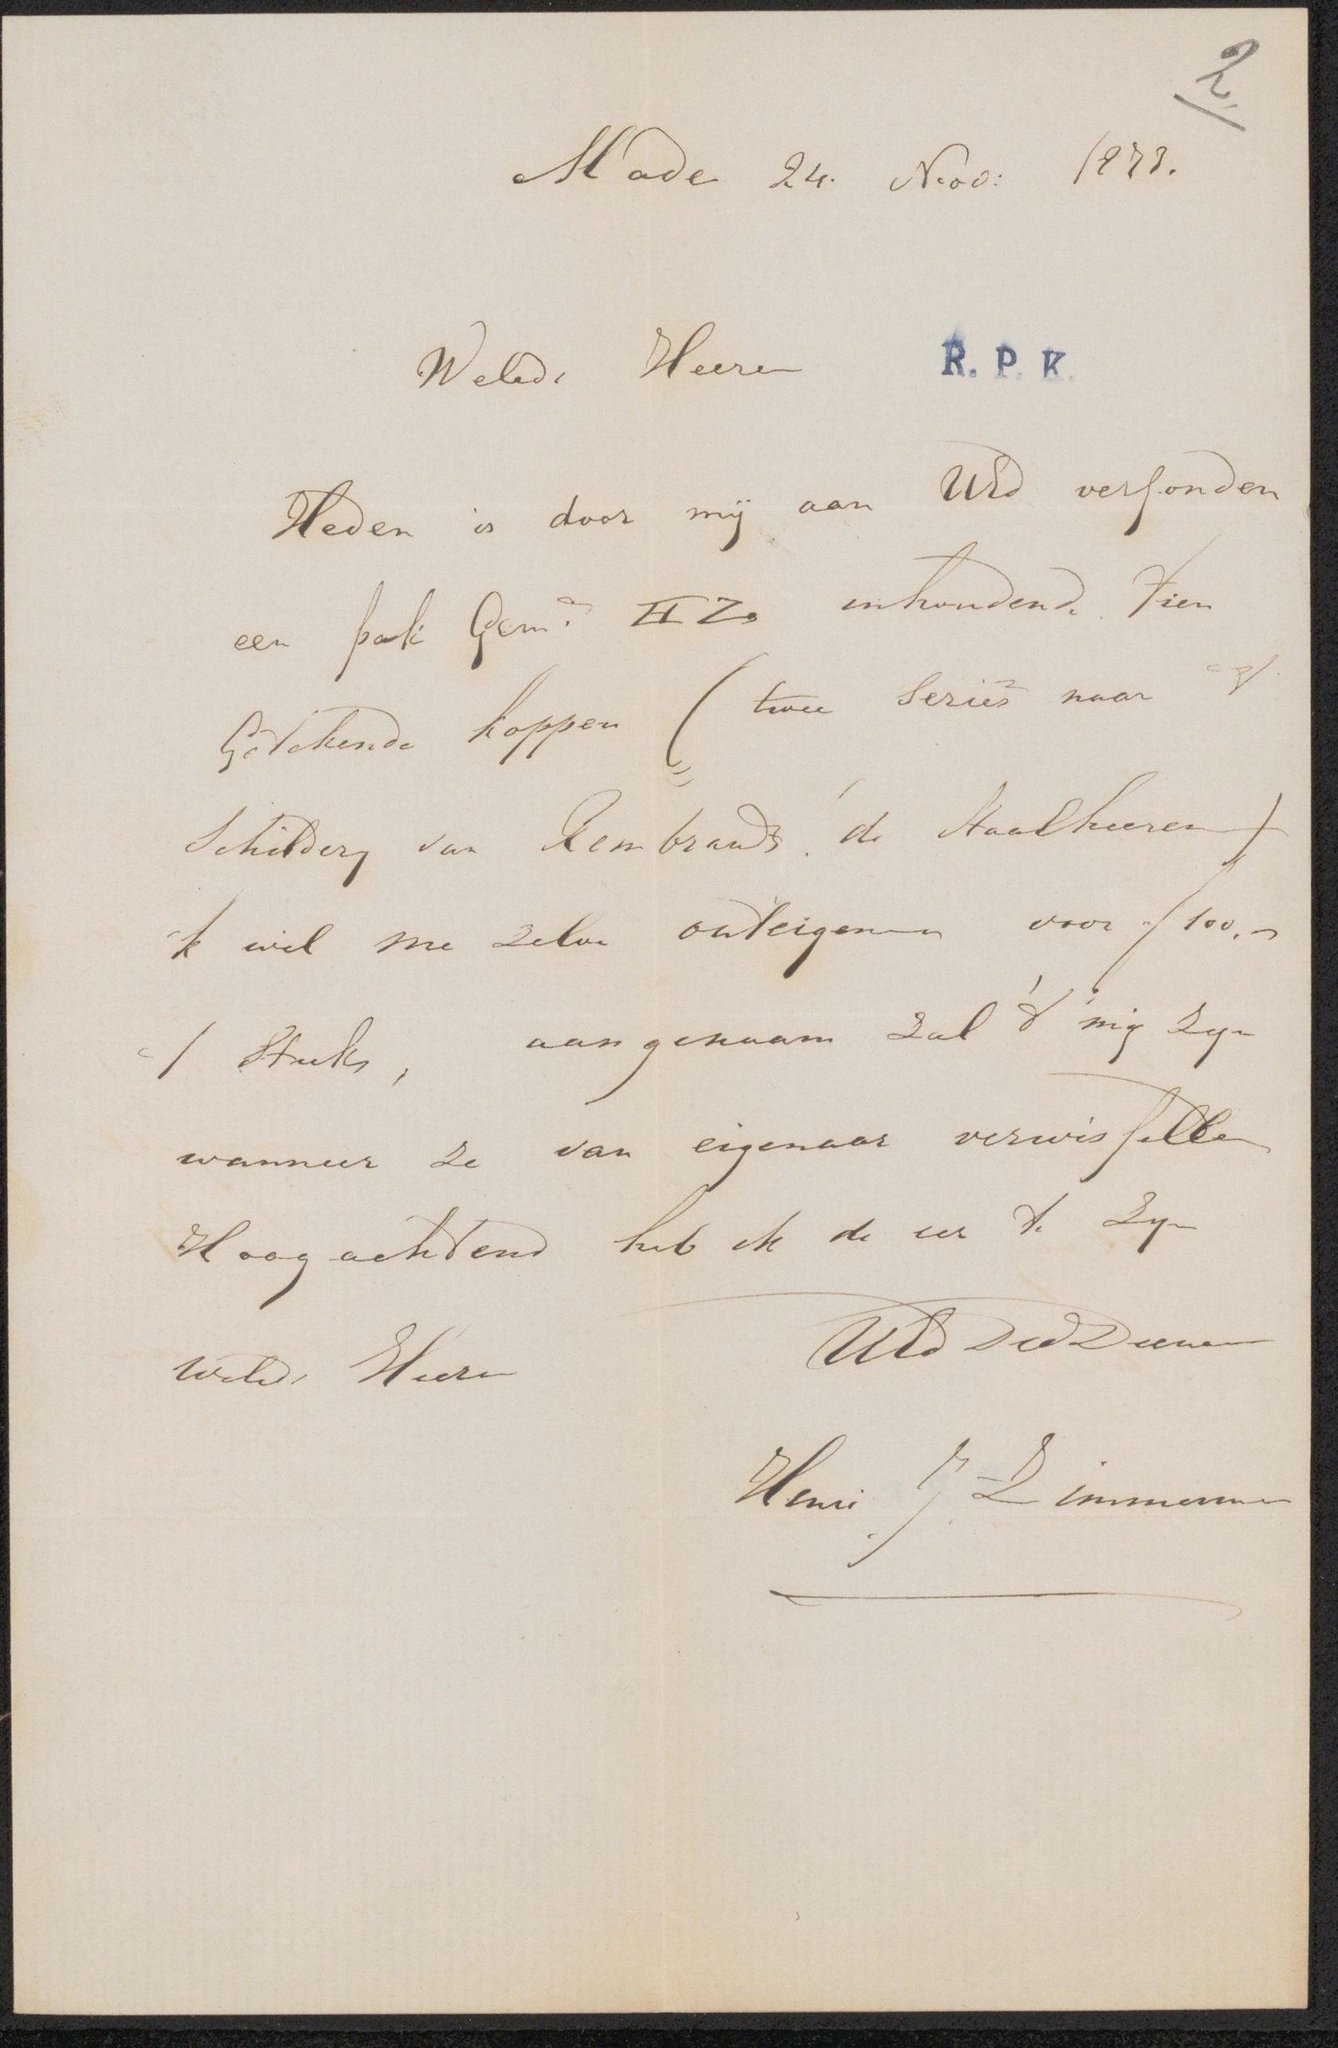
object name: letter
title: Brief aan Frans Buffa en Zonen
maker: hendrik jan zimmerman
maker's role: bookseller, publisher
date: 1873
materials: ink, paper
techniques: pen, writing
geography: the hague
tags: publisher, leiden, painter, print maker, draughtsman, rembrandt van rijn, the graphic arts, money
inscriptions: collector's mark: Lugt 2233